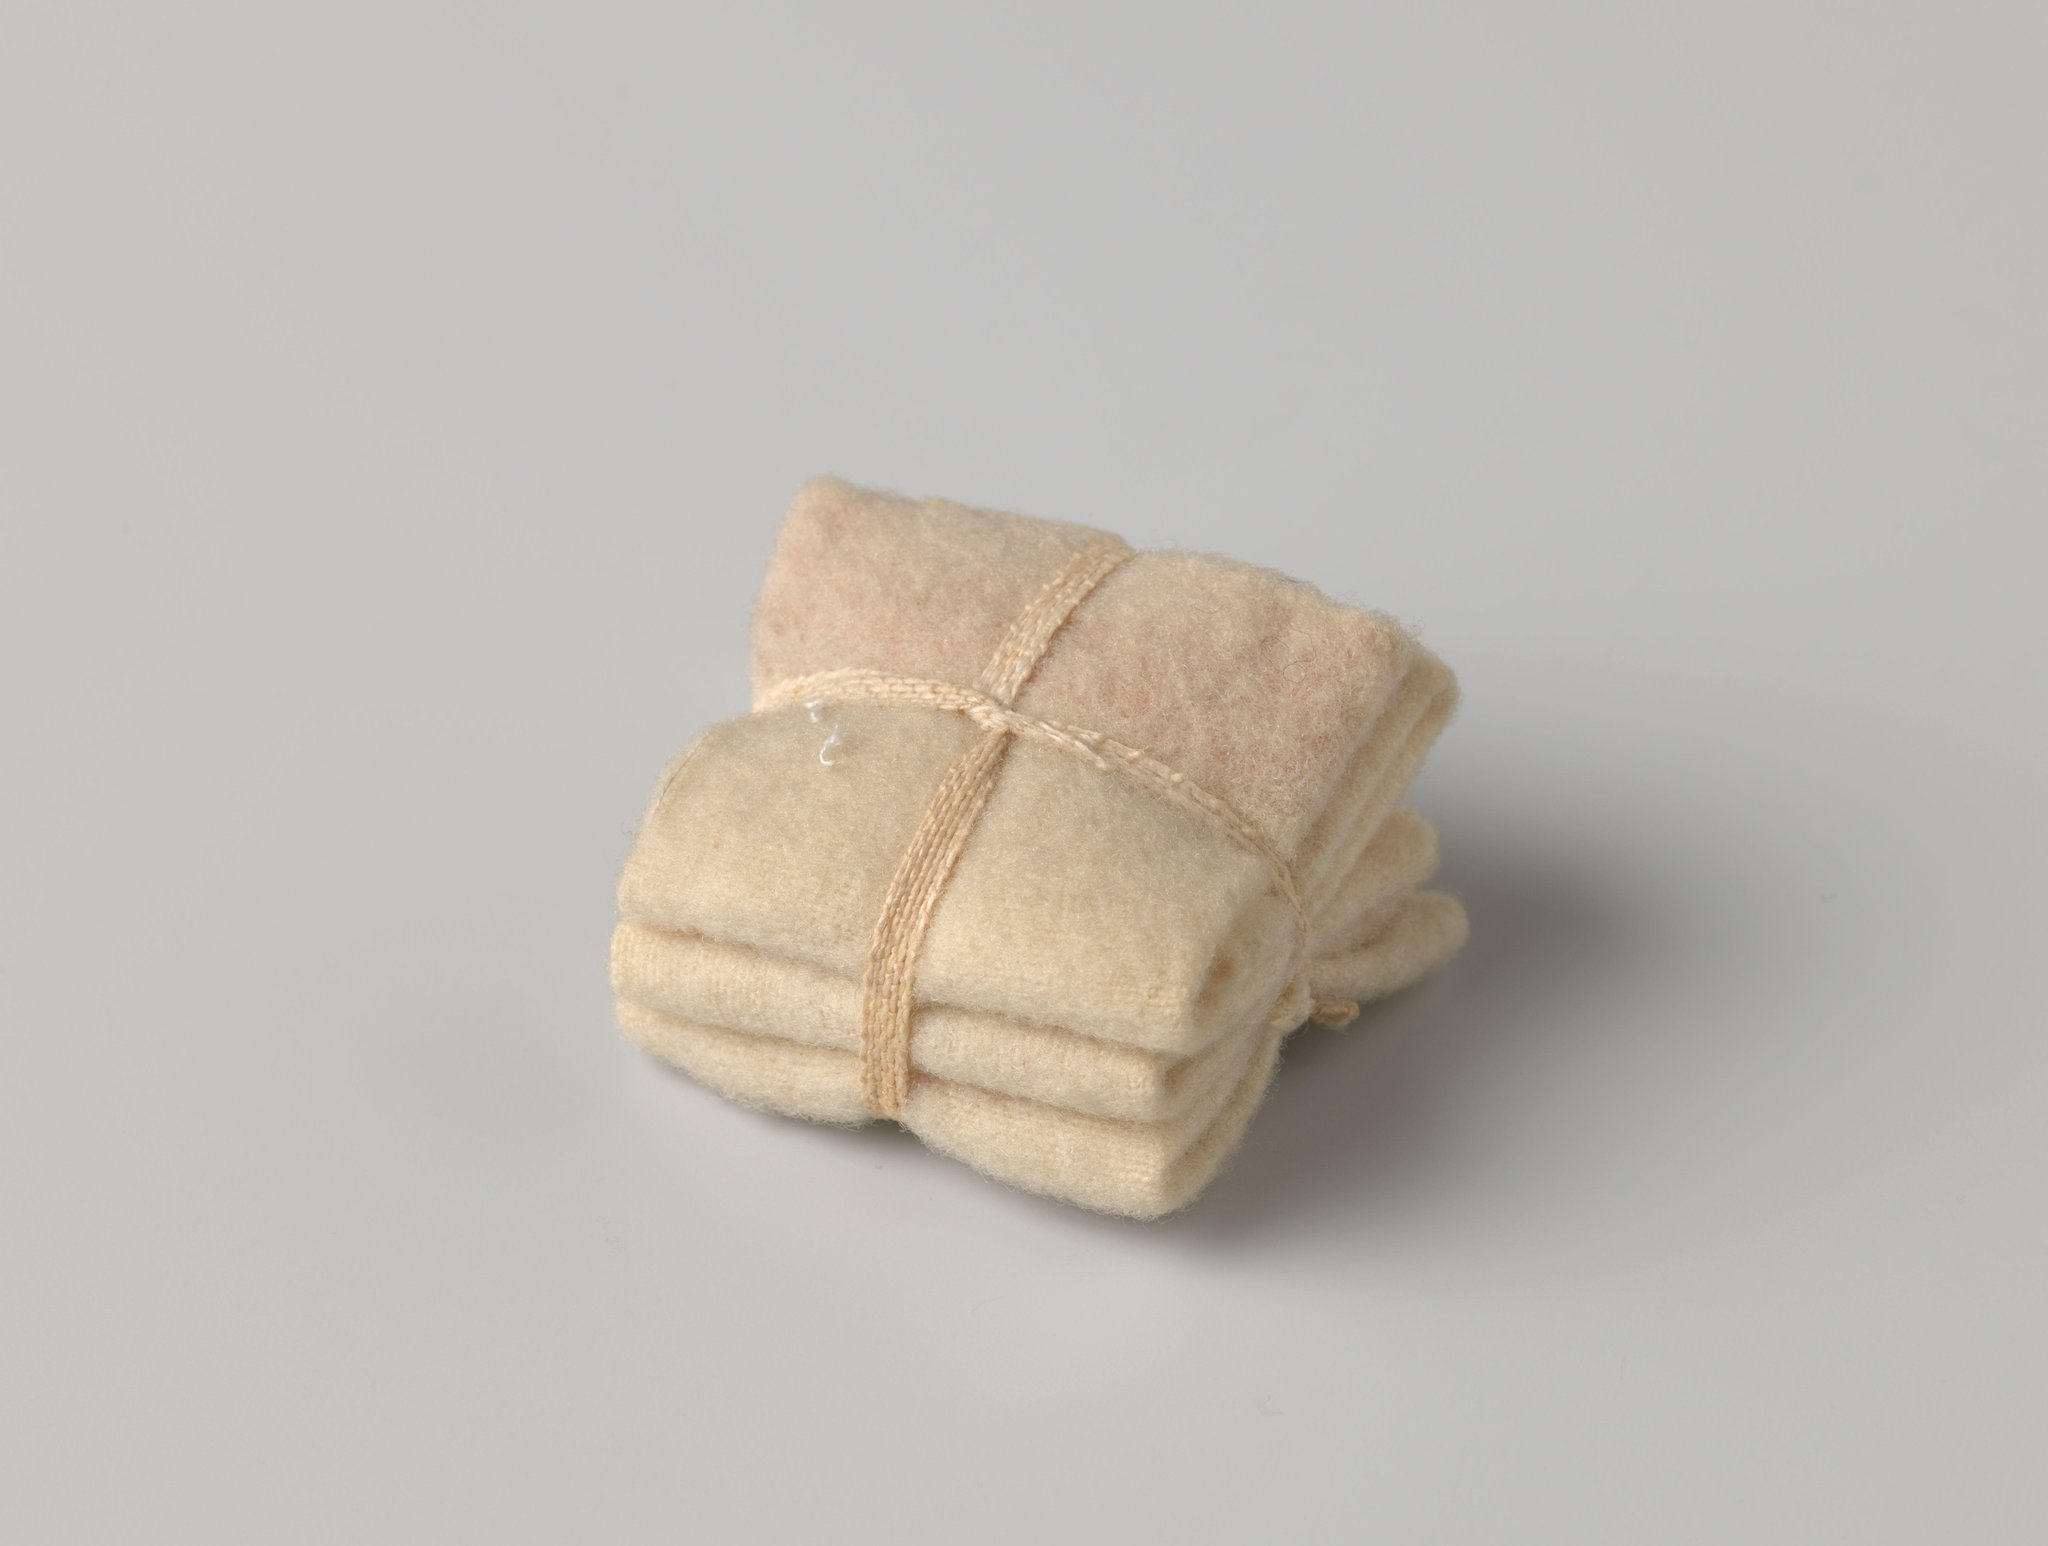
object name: miniature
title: Stapel dekens, samengebonden met een band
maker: Anonymous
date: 1750-1800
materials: linen, wool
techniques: napping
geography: netherlands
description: Een stapel van drie opgevouwen en samengebonden wollen dekens (?) gebundeld met linnen band.